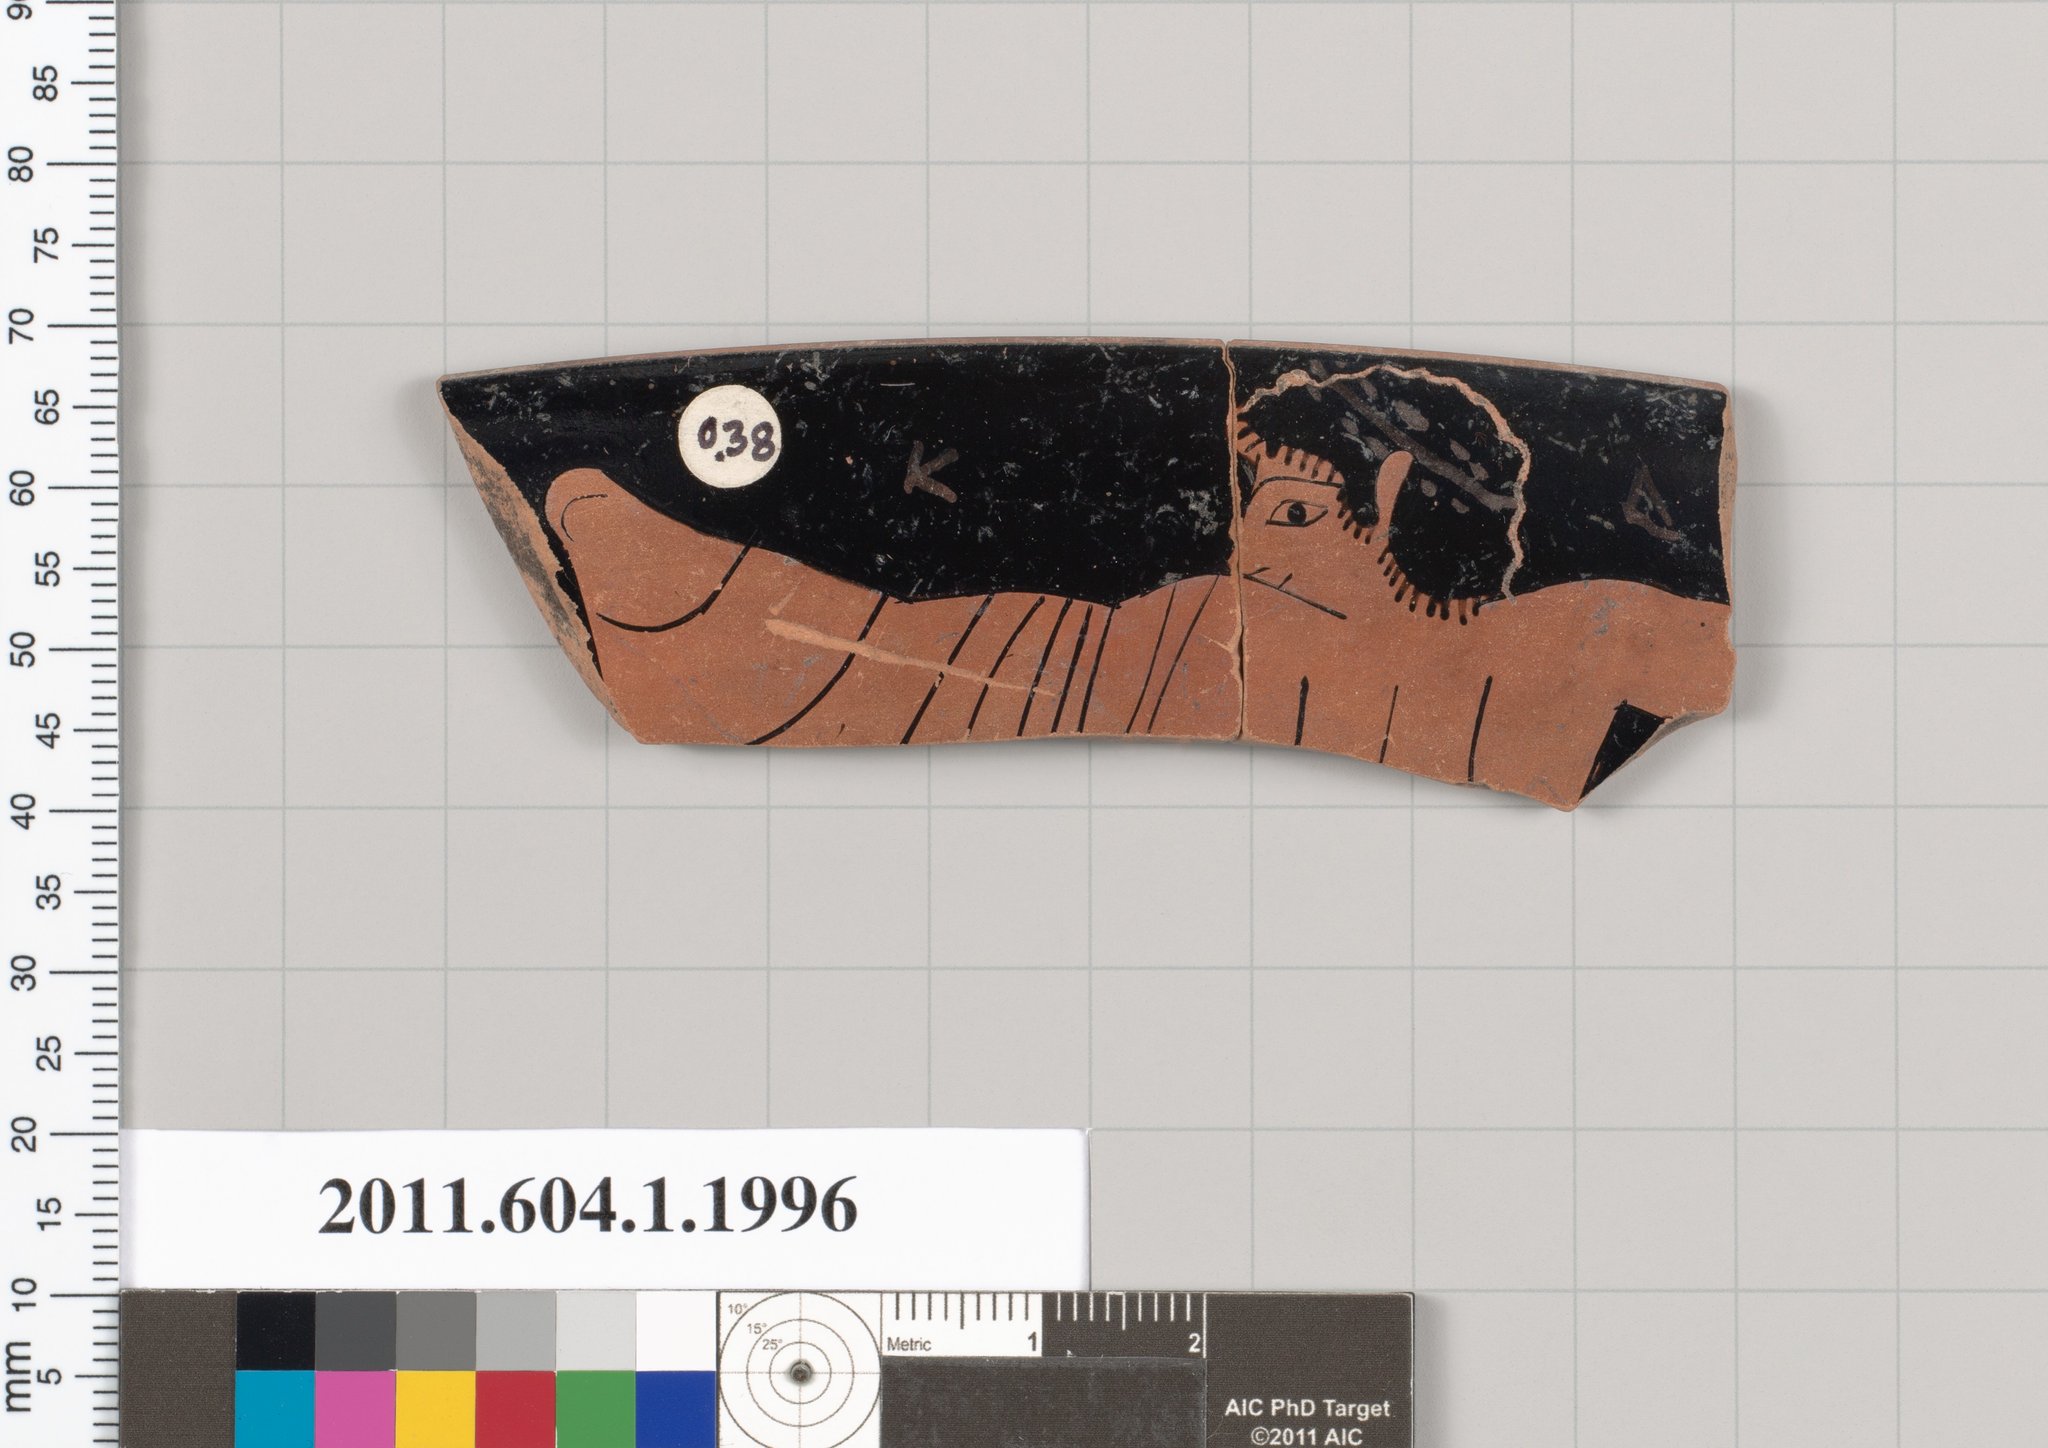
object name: kylix fragment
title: Terracotta rim fragment of a kylix (drinking cup)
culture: greek, attic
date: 534-501 BCE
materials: terracotta